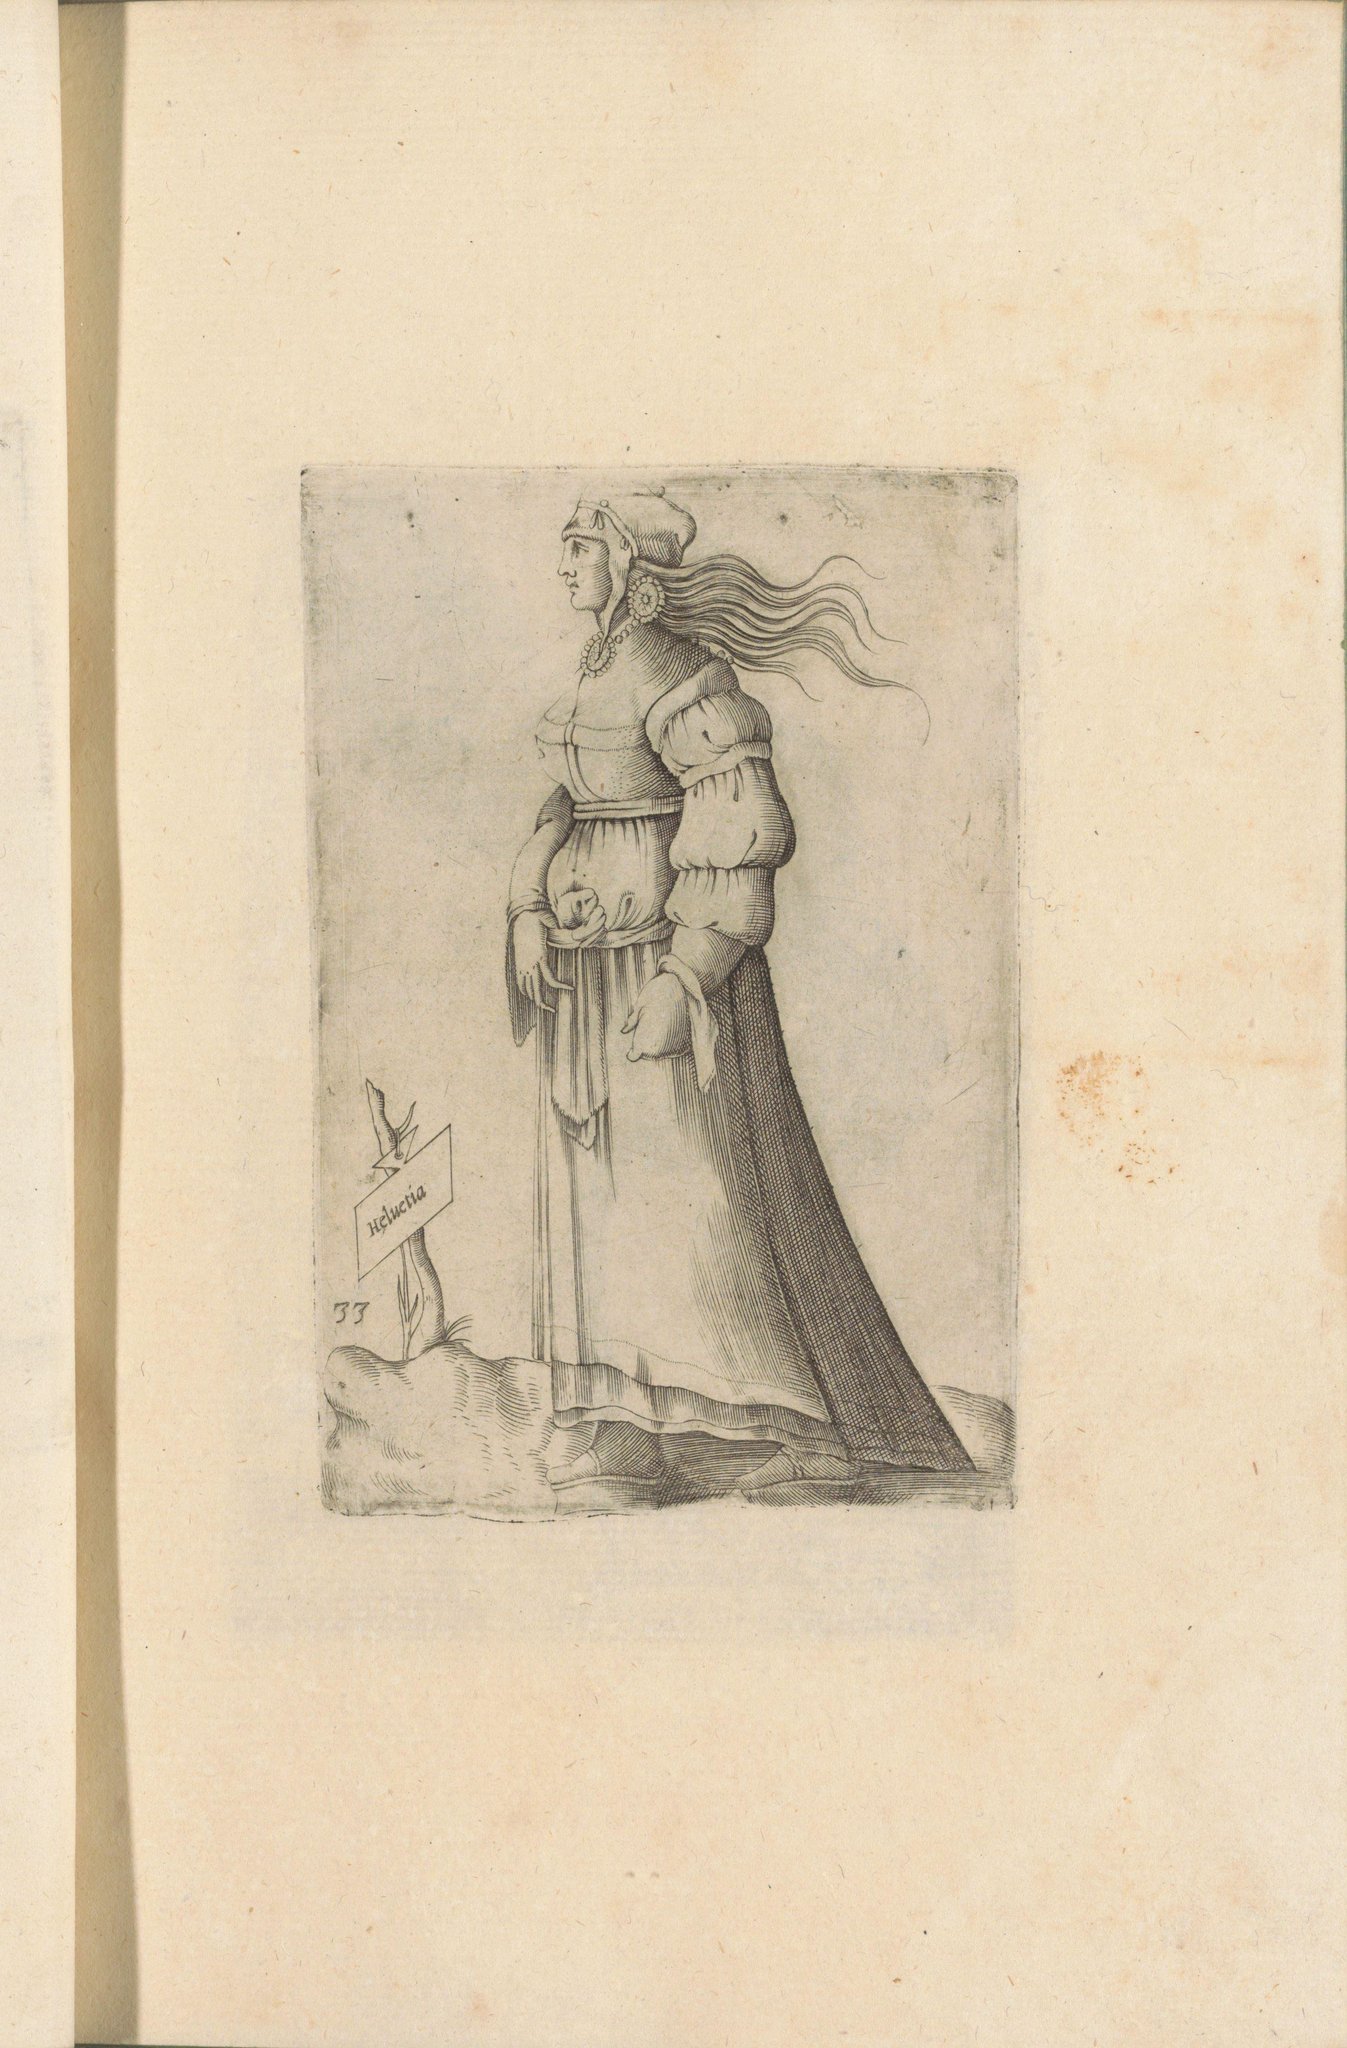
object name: costume print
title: Omnium fere gentium nostrae aetatis habitus, nunquam ante hac aediti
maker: ferando bertelli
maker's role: print maker, publisher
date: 1569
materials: paper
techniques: engraving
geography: venice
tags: fashion plates, switzerland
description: Vrouw uit Zwitserland, naar links met losse wapperende haren. Onderdeel van het kostuumboek getiteld 'Omnium fere gentium nostrae aetatis habitus, nunquam ante hac aediti', Venetië 1569. Heruitgave uit 1569 van de eerste editie uit 1563.